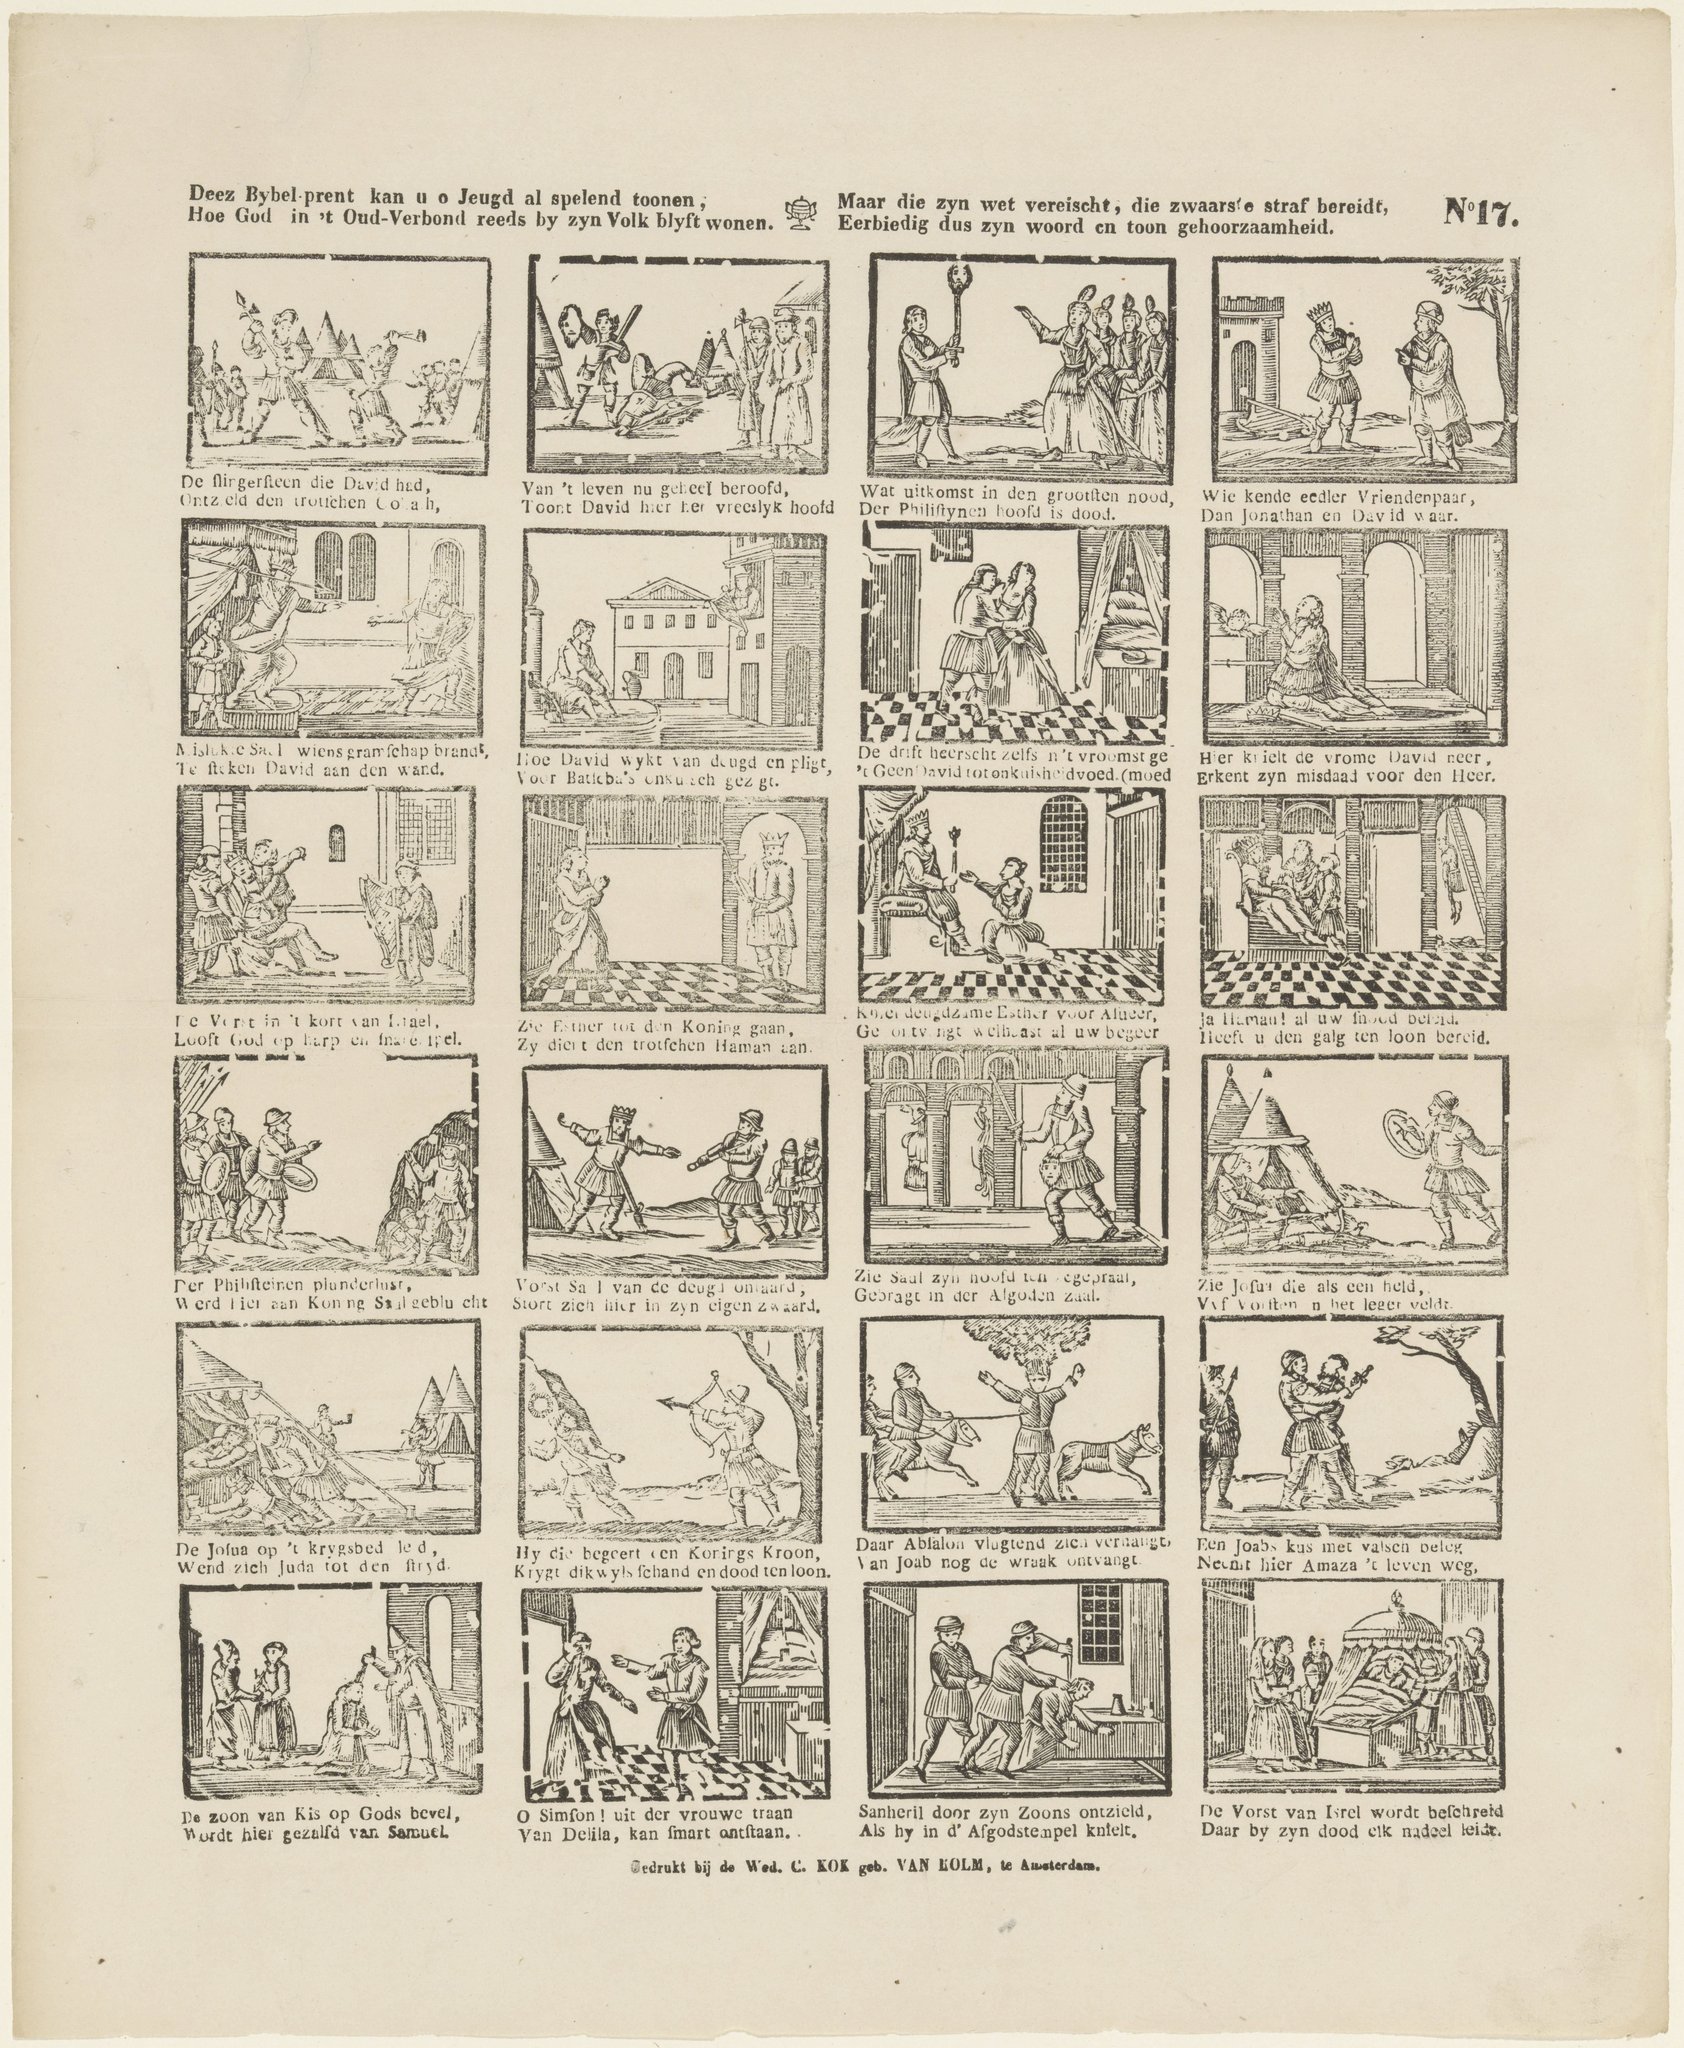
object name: print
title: Deez' bybel-prent kan u, o jeugd! al spelend toonen, / Hoe God in 't oude Verbond reeds by zyn volk blyft wonen, / Maar die zyn wer veracht, de zwaarste straf bereidt, / Eerbiedig dus zyn woord en toon gehoorzaamheid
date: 1842-1866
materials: paper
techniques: letterpress printing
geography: amsterdam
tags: story of saul's death, the meeting of samson and delilah, story of david, old testament, david as a young man at saul's court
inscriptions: collector's mark: Lugt 2760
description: Blad met 24 voorstellingen uit het het Oude Testament, waaronder David die het afgehakte hoofd van Goliat toont, Saul die zich in zijn eigen zwaard stort en Samson en Delila. Onder elke voorstelling een tweeregelig vers. Genummerd rechtsboven: No. 17.